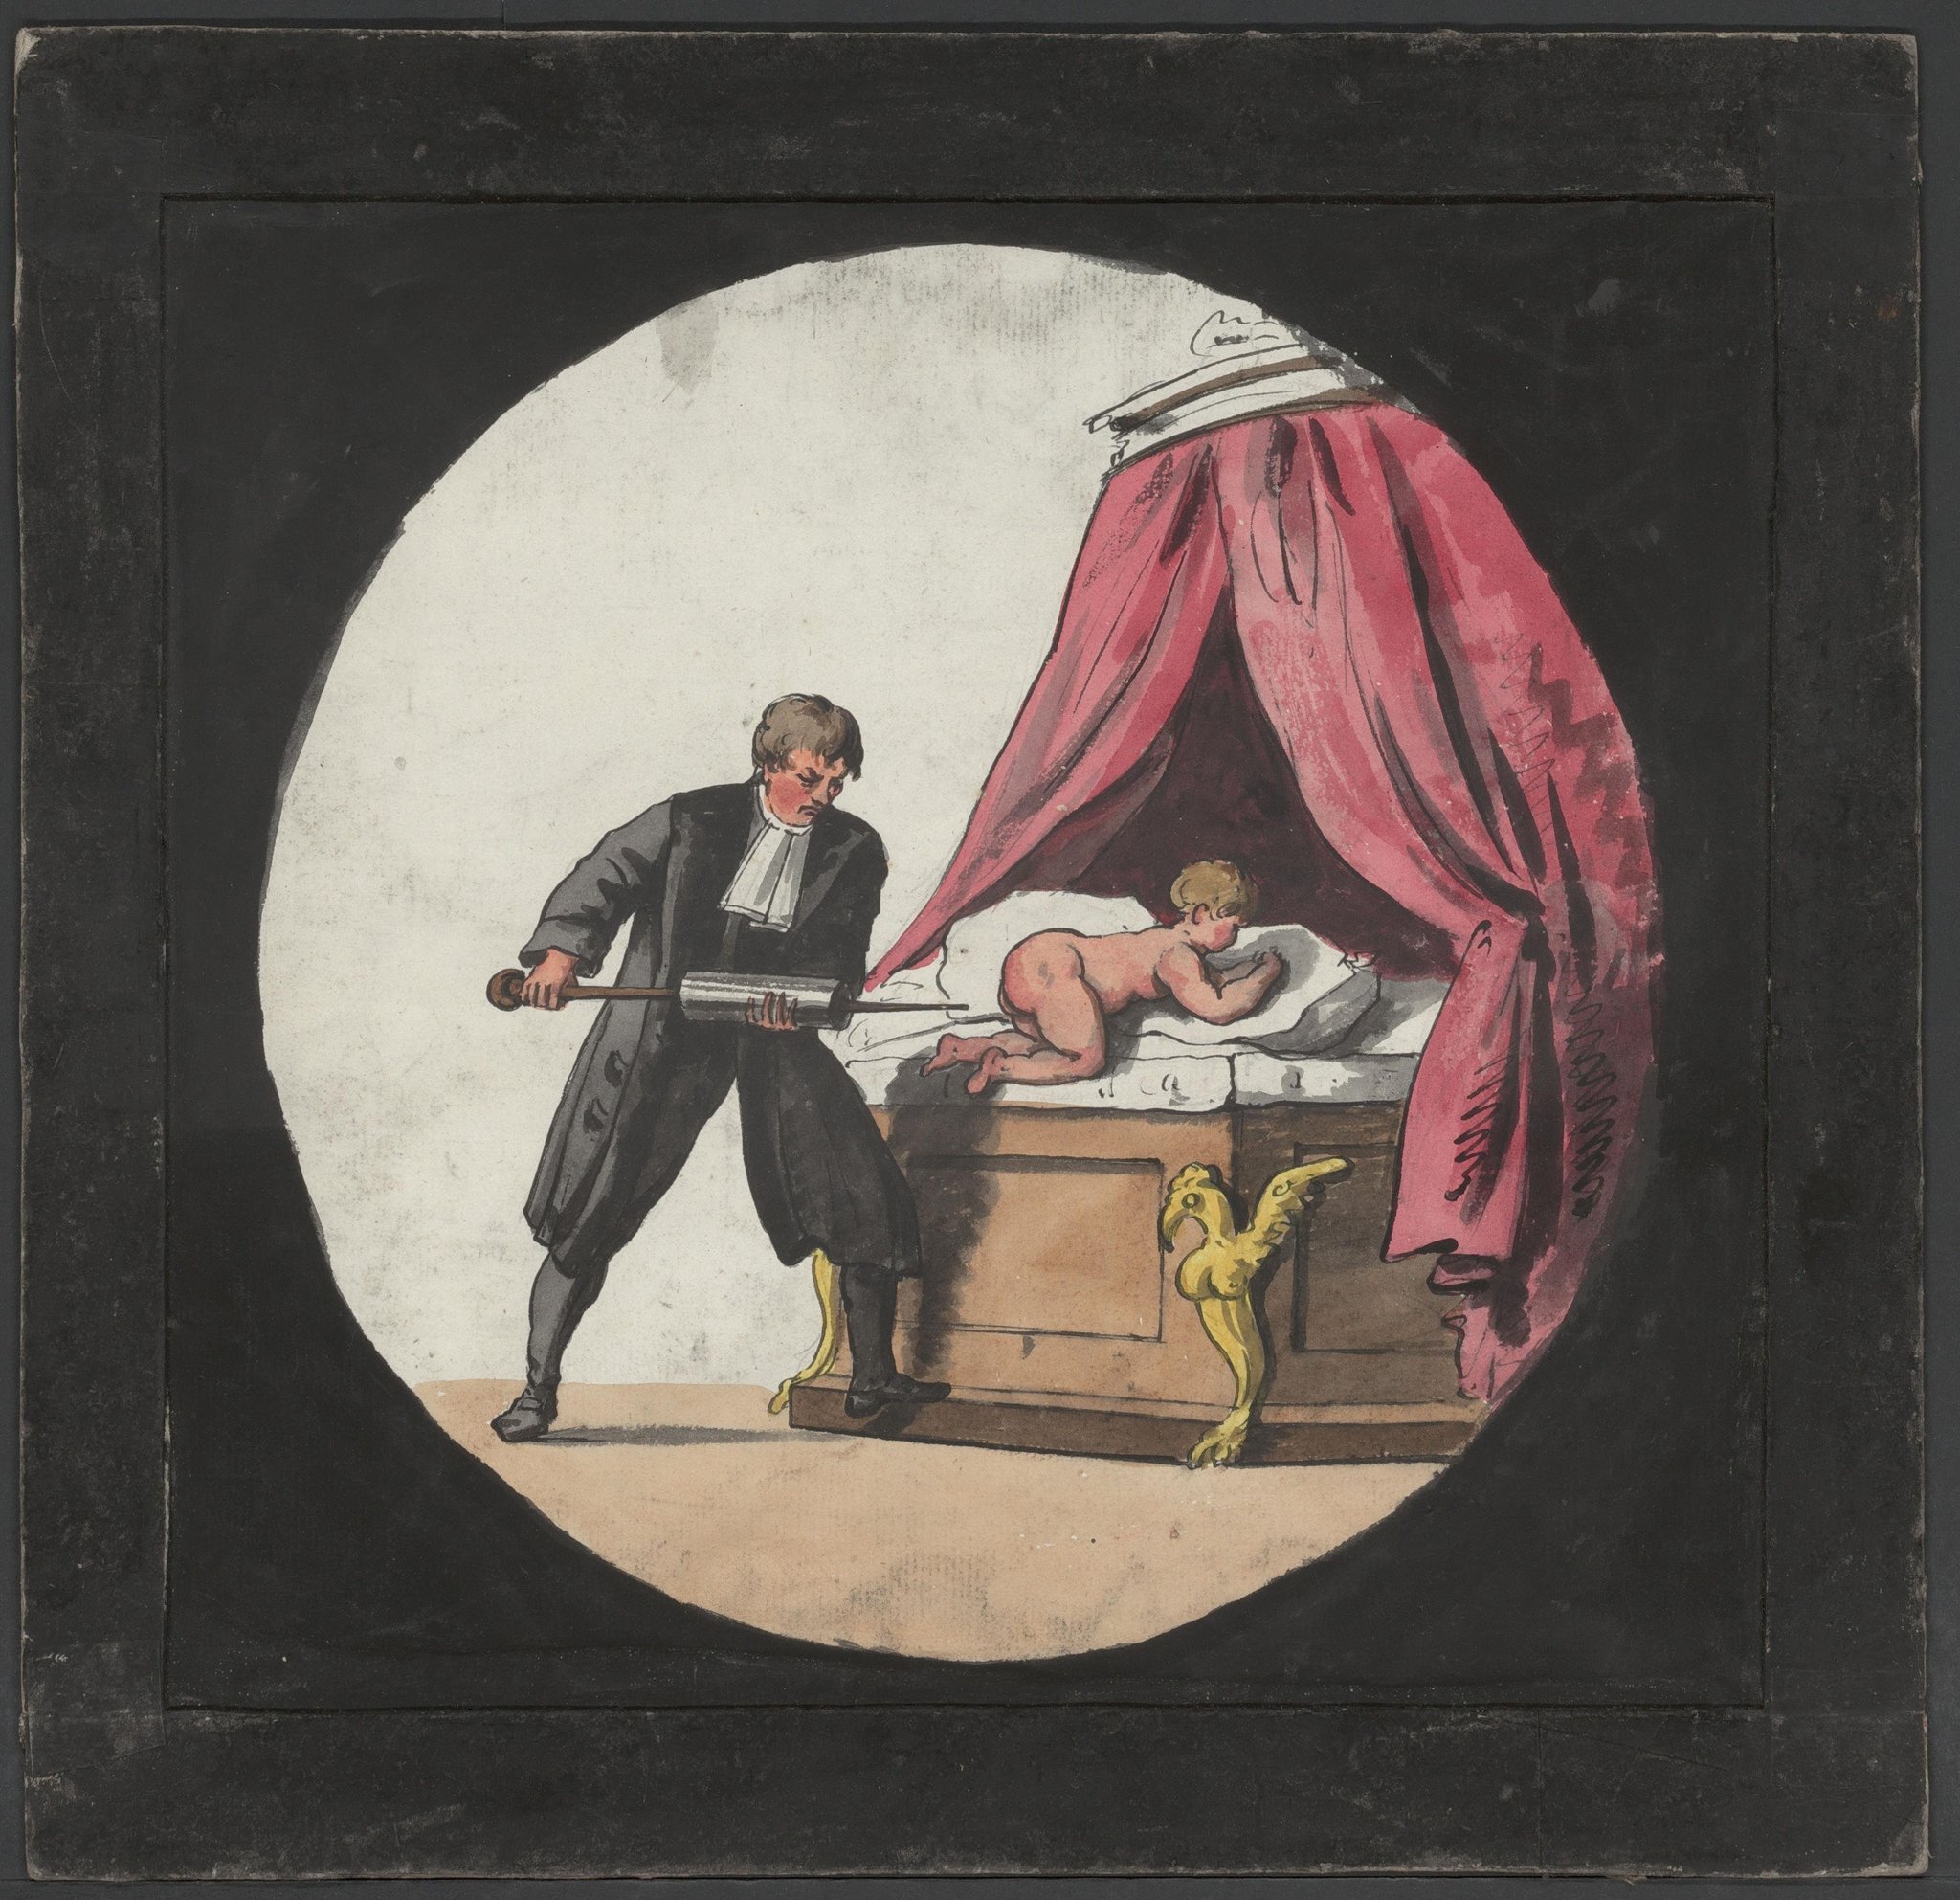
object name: drawing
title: Arts behandelt een kind met een klisteerspuit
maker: jacob willemz. de vos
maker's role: draughtsman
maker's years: 1774-1844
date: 1800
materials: cardboard, ink, paper, watercolor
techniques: brush, pen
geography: netherlands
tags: amsterdam, utrecht, enema, squirt, administering, taking medicine, medical examination, medical treatment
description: Een man staat op het punt een kind dat op een bed ligt, met een enorme klisteerspuit te behandelen. Mogelijk dokter Daniel Dijlius. Onderdeel van een serie van elf ronde tekeningen die mogelijk als toverlantaarnplaat zijn gemaakt.